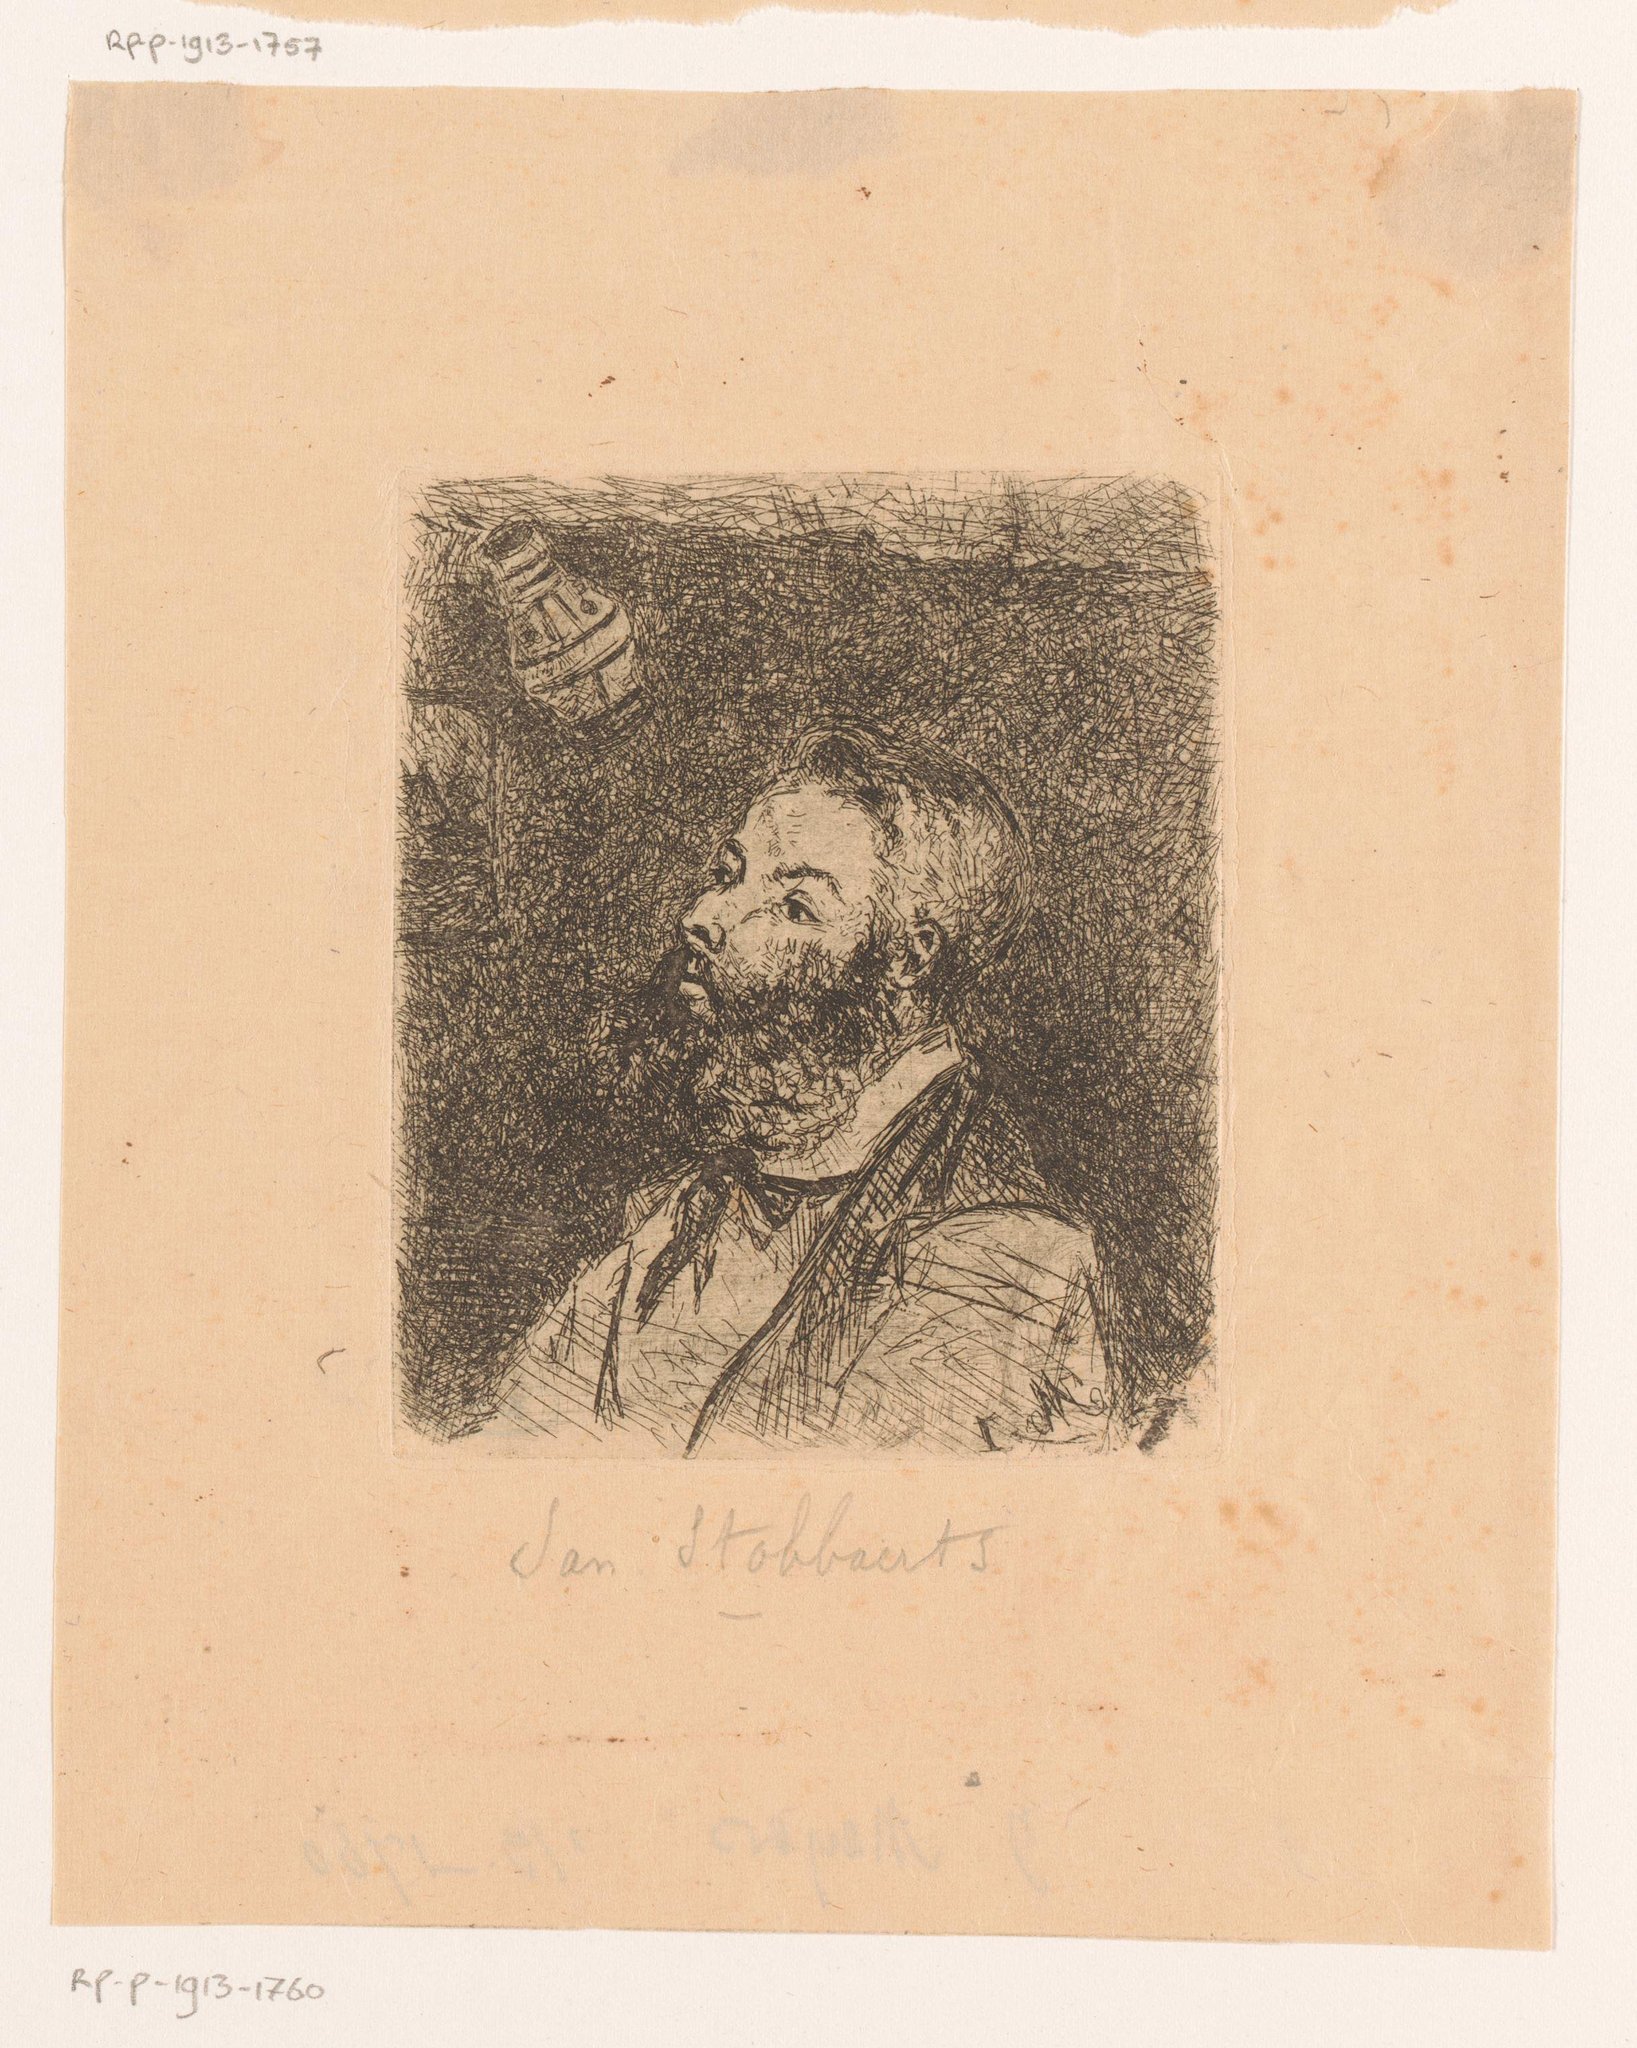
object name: print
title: Portret van Jan Stobbaerts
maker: isidore meyers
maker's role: print maker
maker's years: 1836-1917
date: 1846-1913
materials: paper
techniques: etching, intaglio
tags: antwerp, print maker, draughtsman, jan stobbaerts, adult man, historical persons, beard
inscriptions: collector's mark: Lugt 2228